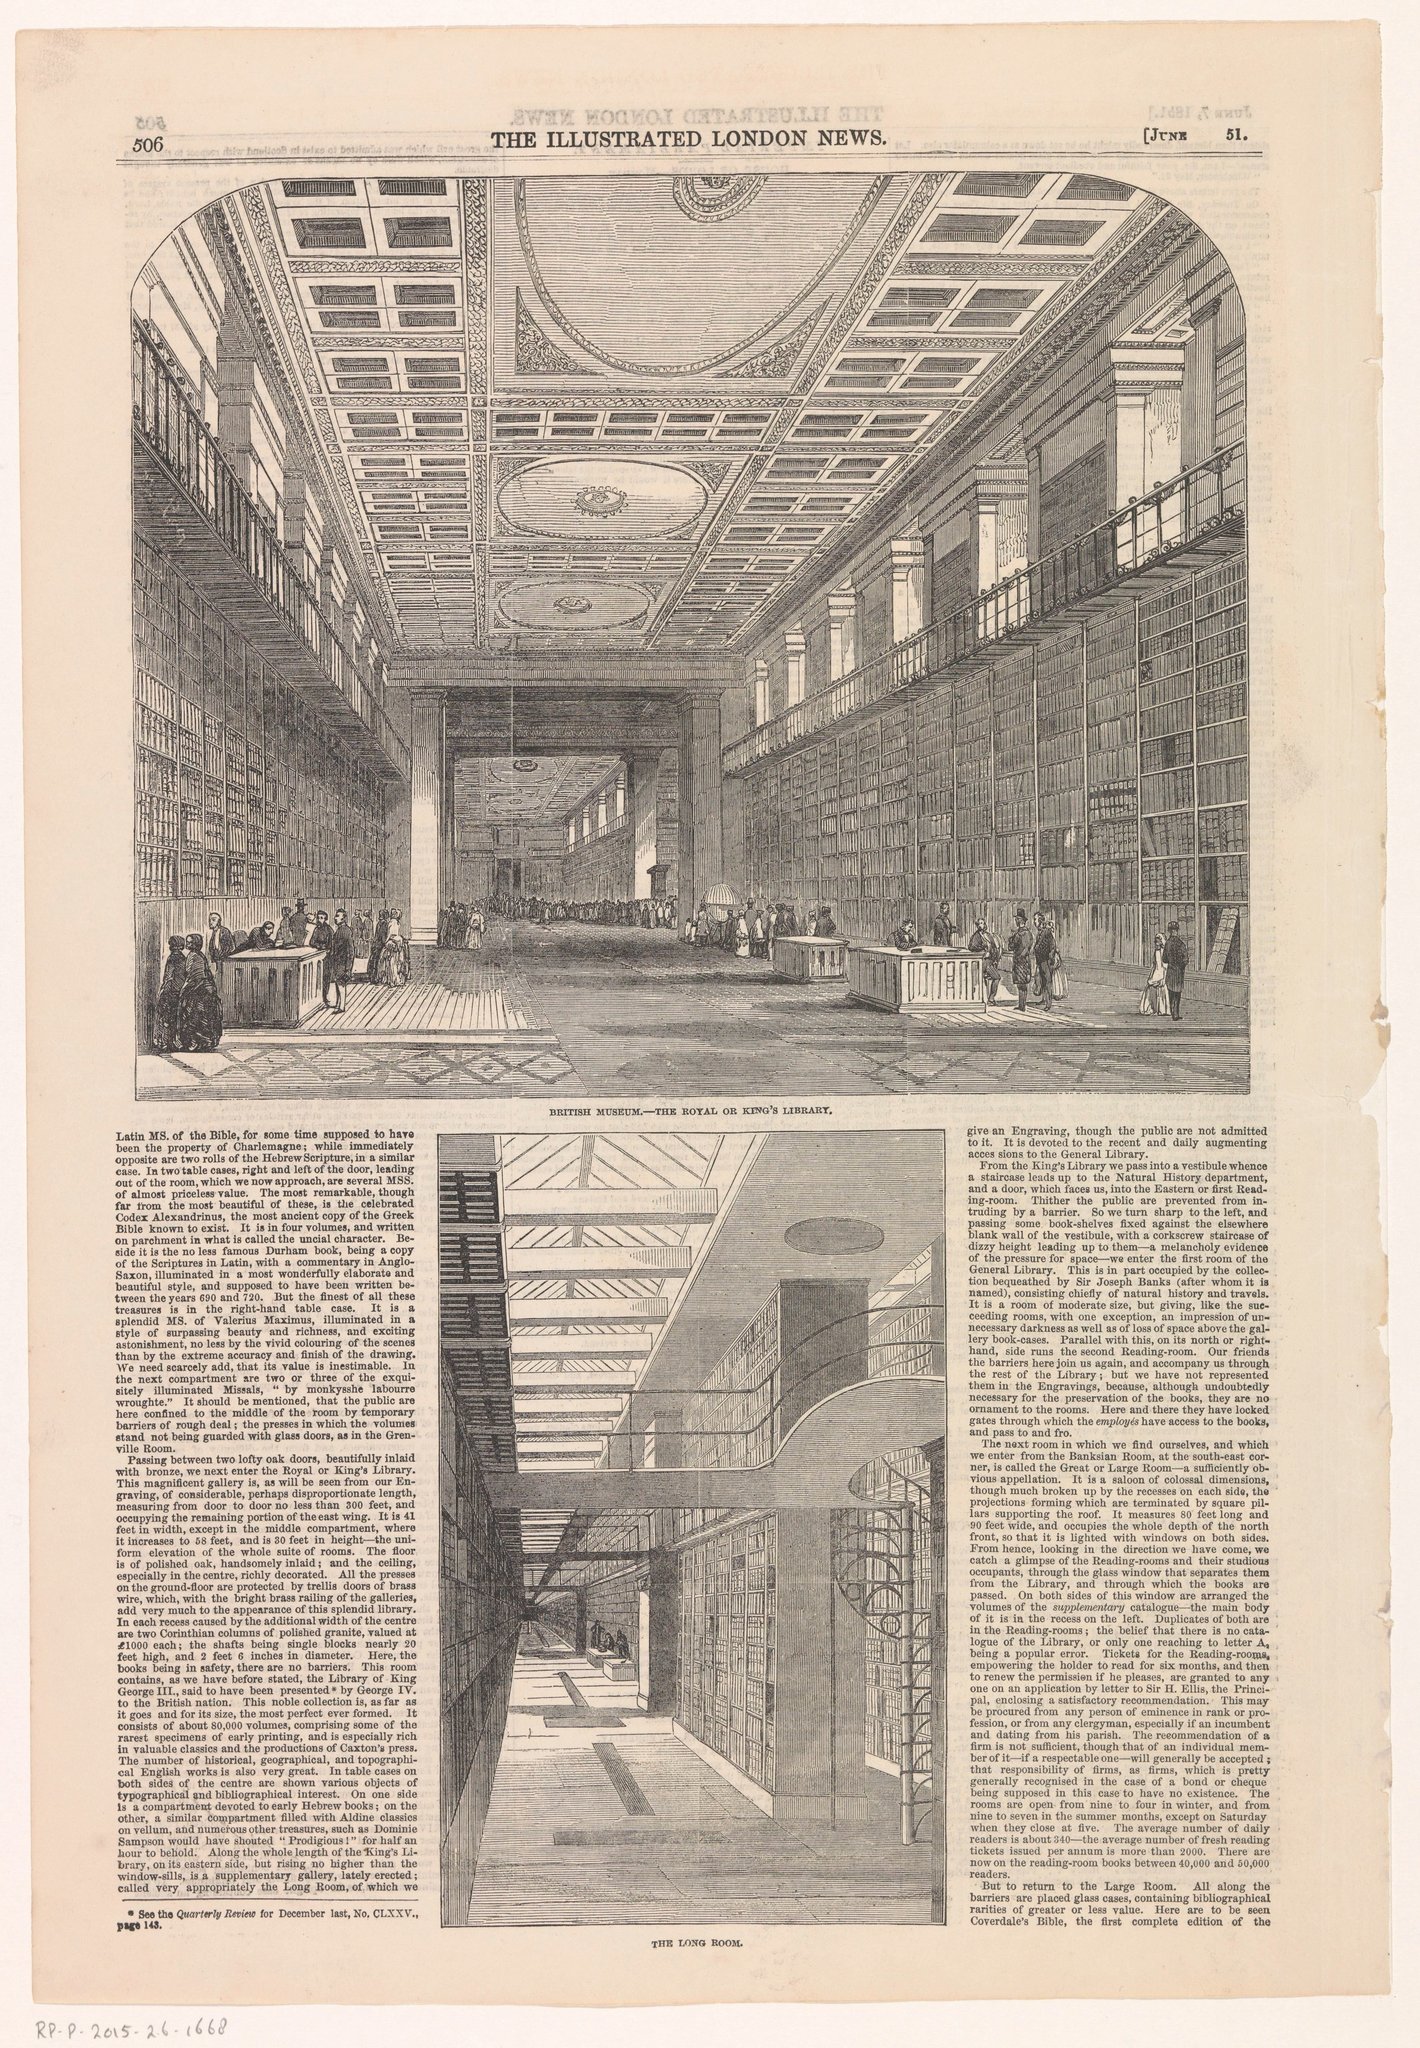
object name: illustration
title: Bibliotheek van het British Museum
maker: Anonymous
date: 1851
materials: paper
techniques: engraving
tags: public library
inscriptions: collector's mark: Lugt 4779, collector's mark: Lugt 2228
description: Tekstblad met twee illustraties. De prenten tonen de bibliotheek van het British Museum: 'King's Library' en 'The Long Room'.